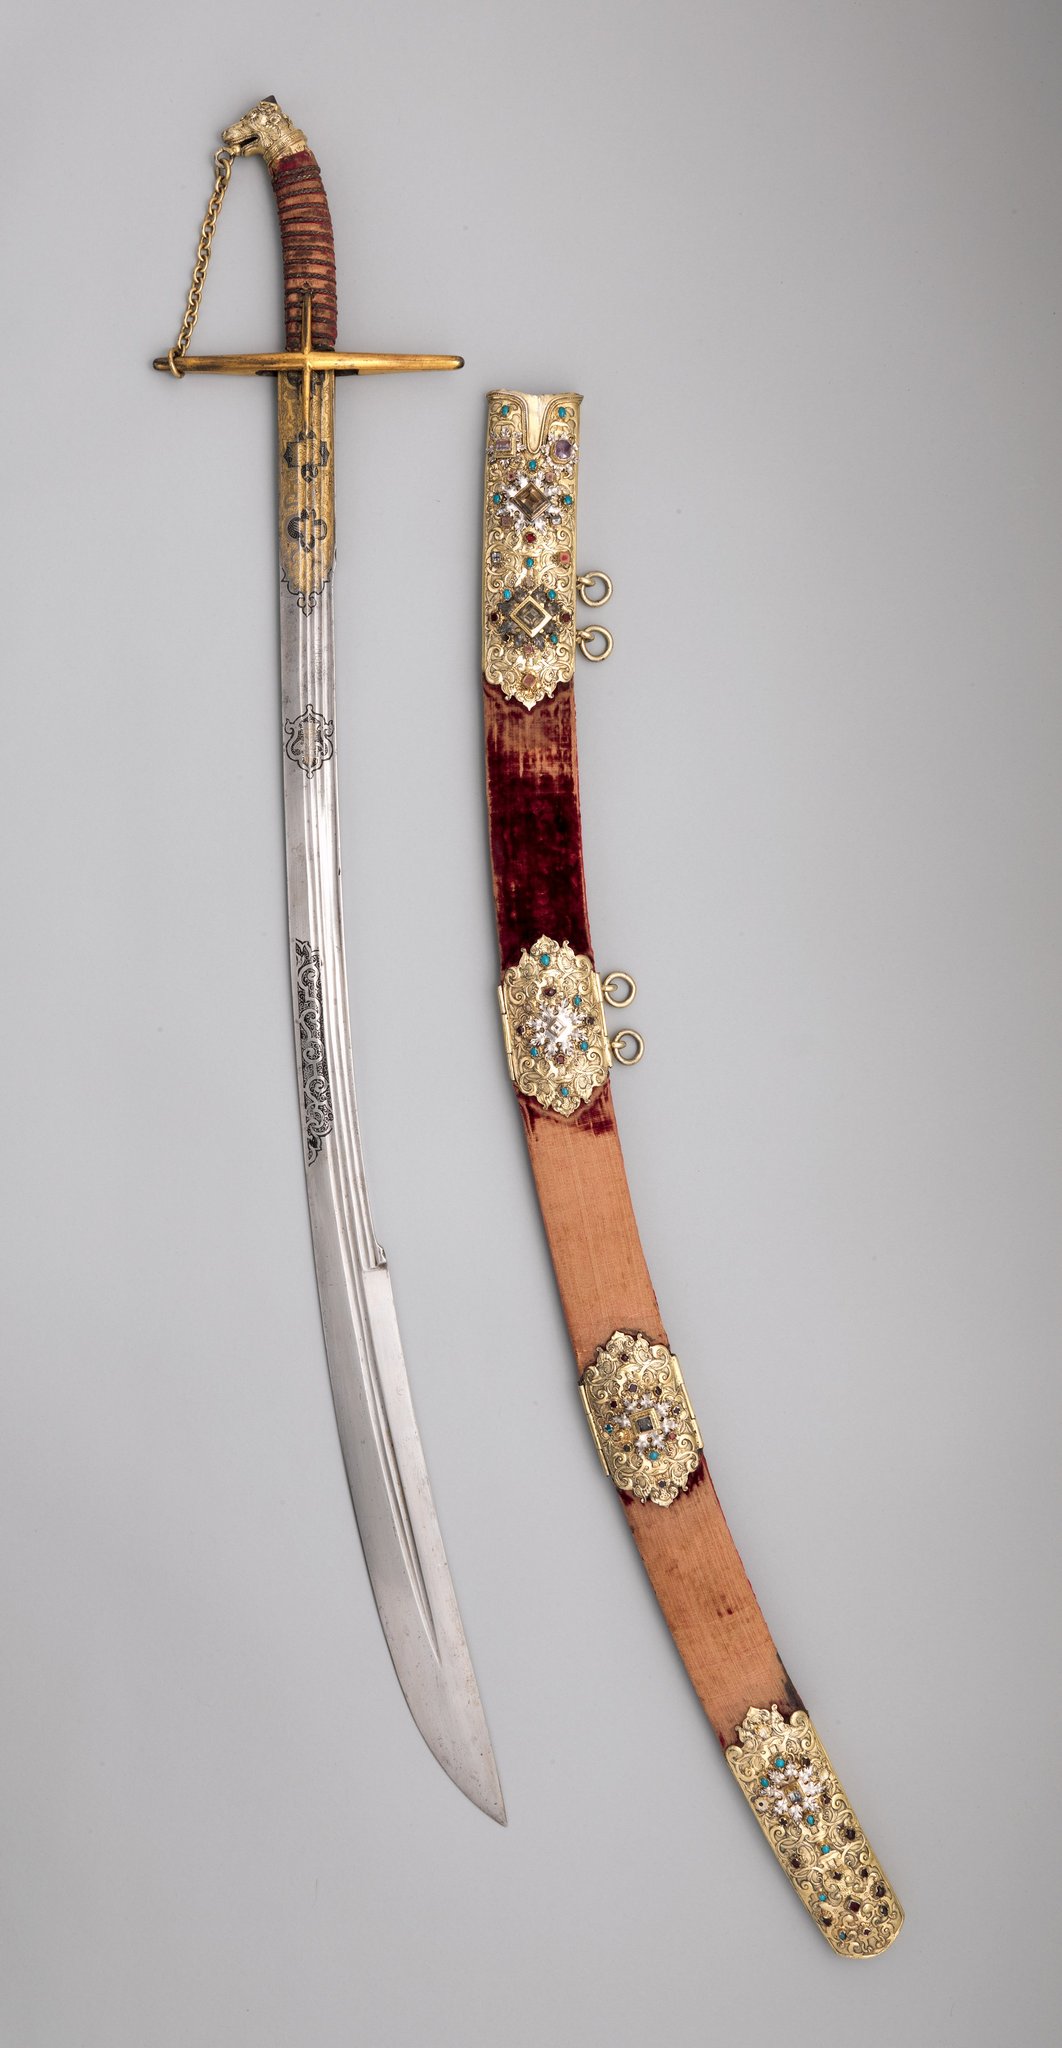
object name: saber with scabbard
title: Saber with Scabbard and Carrying Belt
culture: polish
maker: georg hoffmann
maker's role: goldsmith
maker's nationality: polish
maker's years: 1596-1609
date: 1601-1633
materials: gold, leather, silver, steel, stone, textile, wood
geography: poland